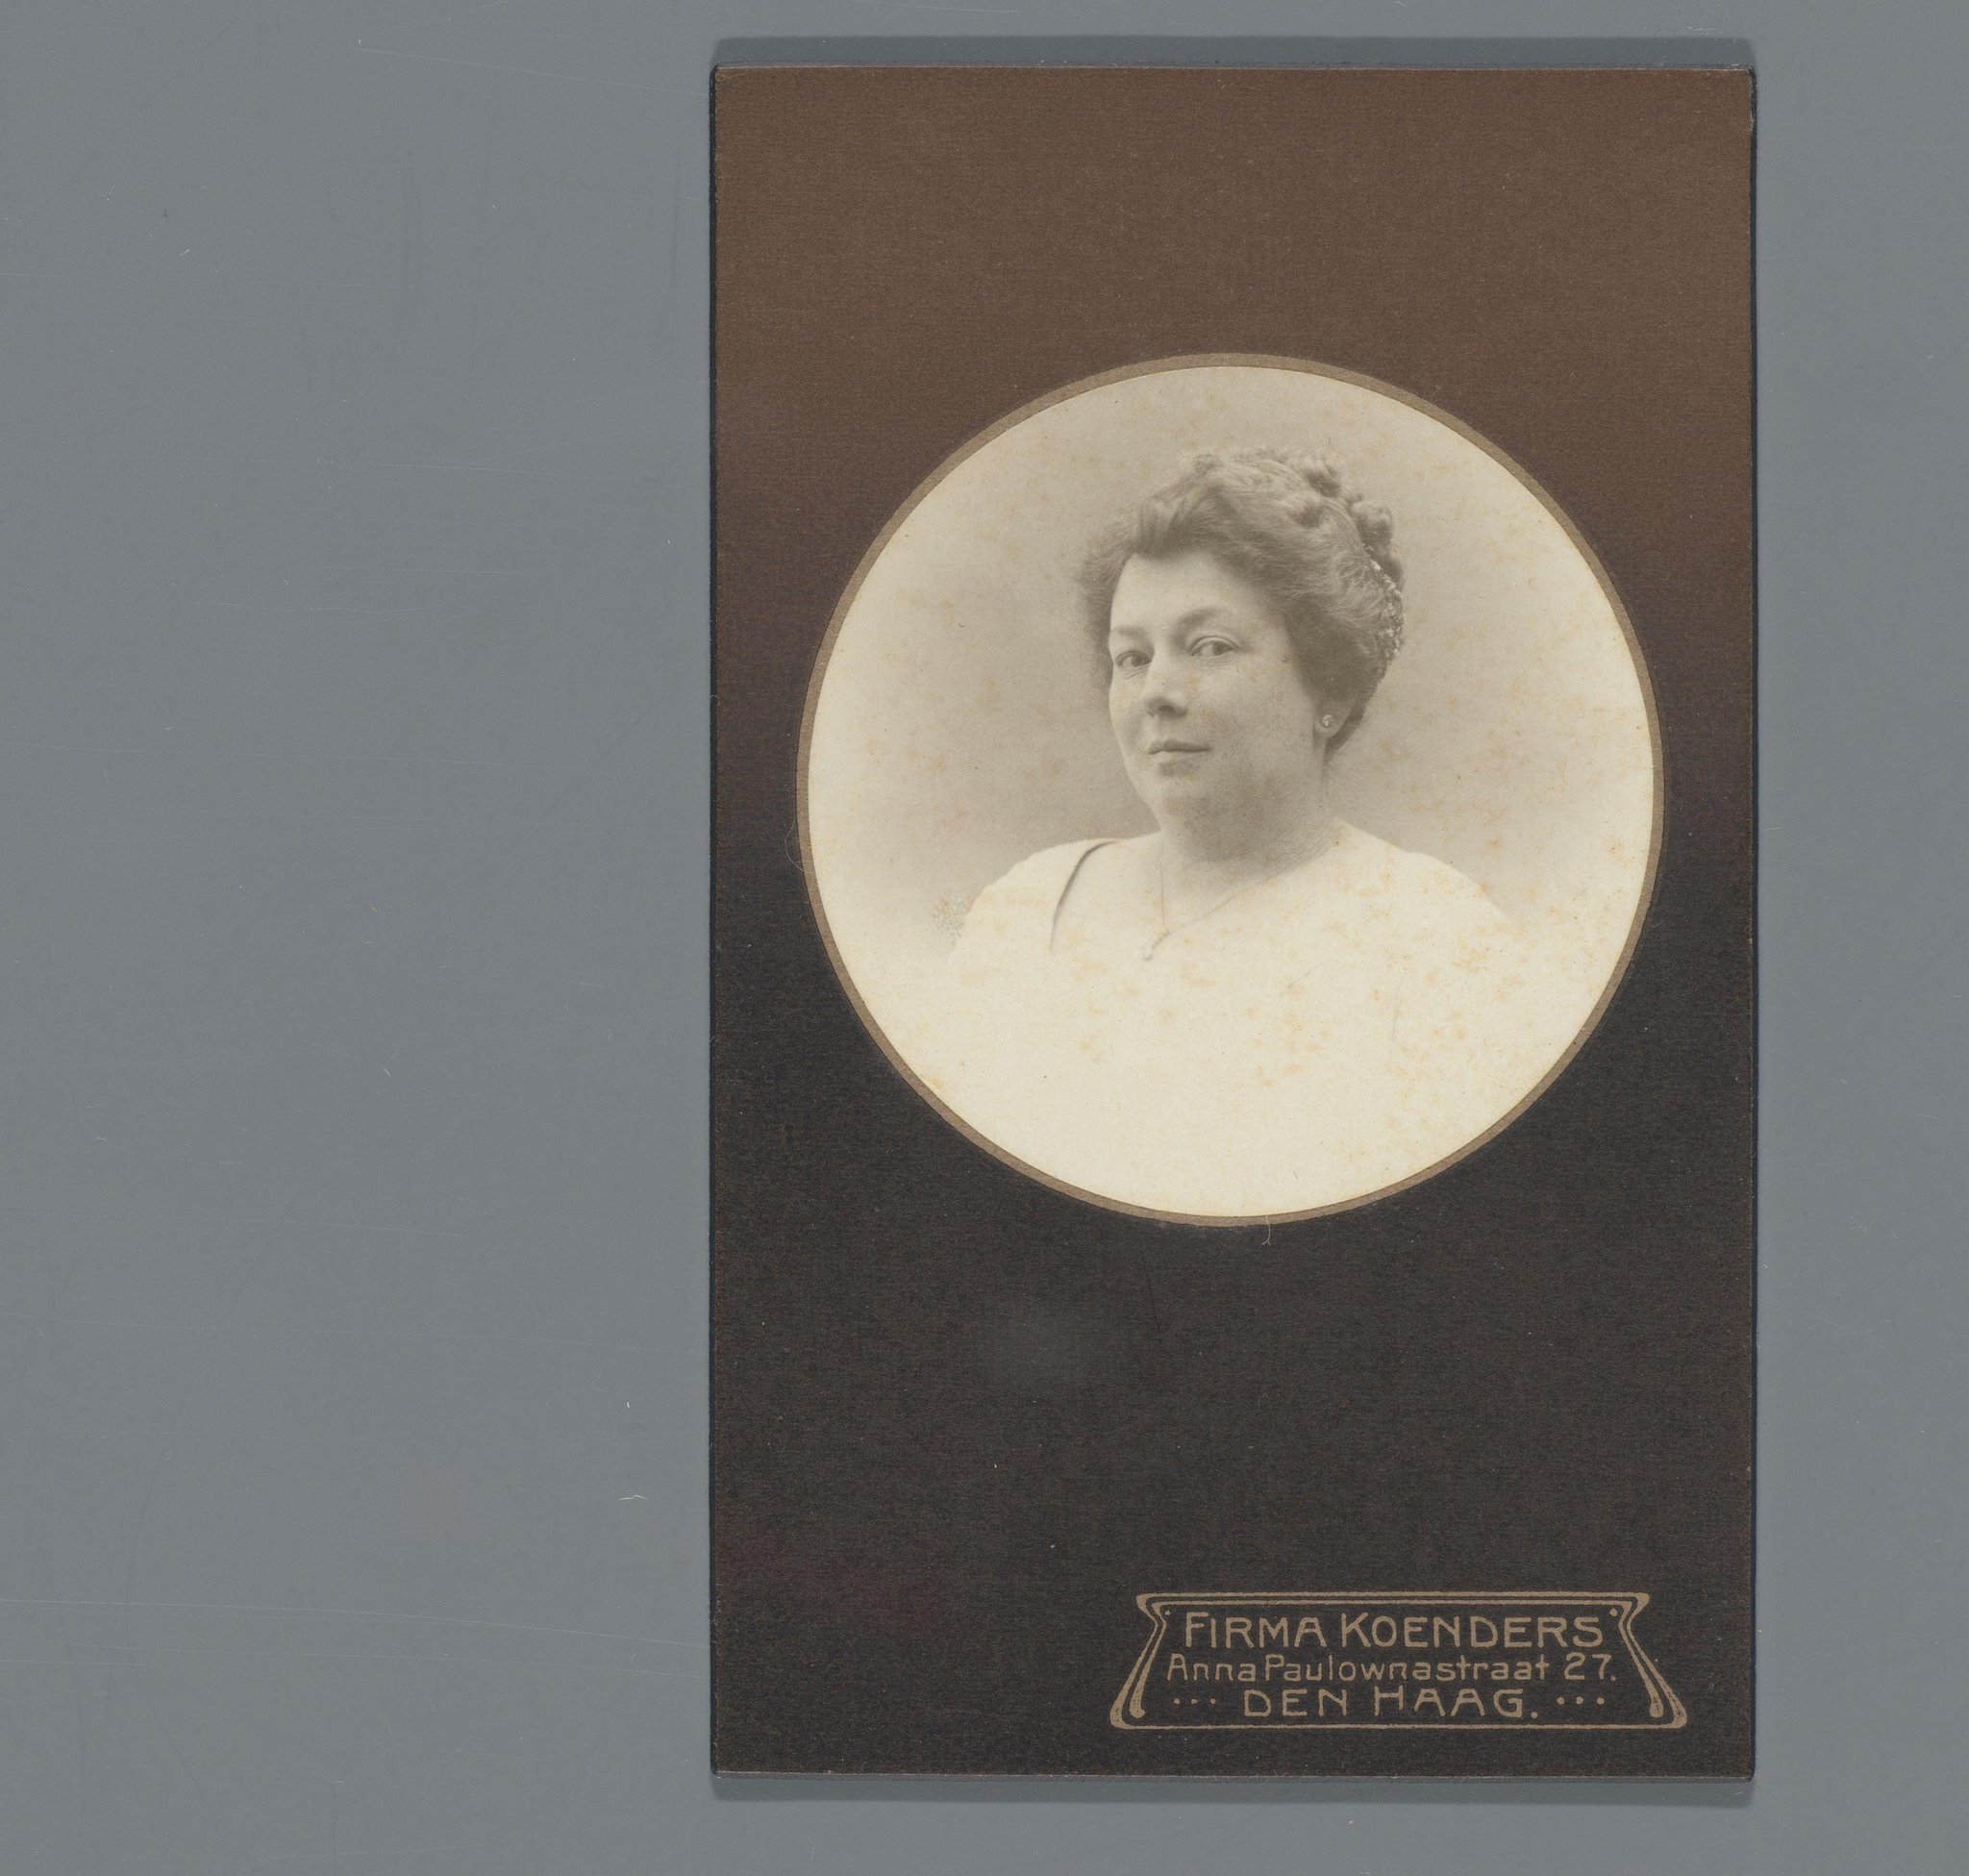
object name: photograph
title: Portret van een onbekende vrouw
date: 1880-1930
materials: cardboard, photographic support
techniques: gelatin silver print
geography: the hague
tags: historical persons not known by name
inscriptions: inscription: ‘FIRMA KOENDERS/ PHOTOGRAPHIE ARTISTIQUE/ 27 Anna Paulownastraat/ LA HAYE.’, inscription: ‘FIRMA KOENDERS/ Anna Paulownastraat 27./ DEN HAAG’, collector's mark: Lugt 2228a